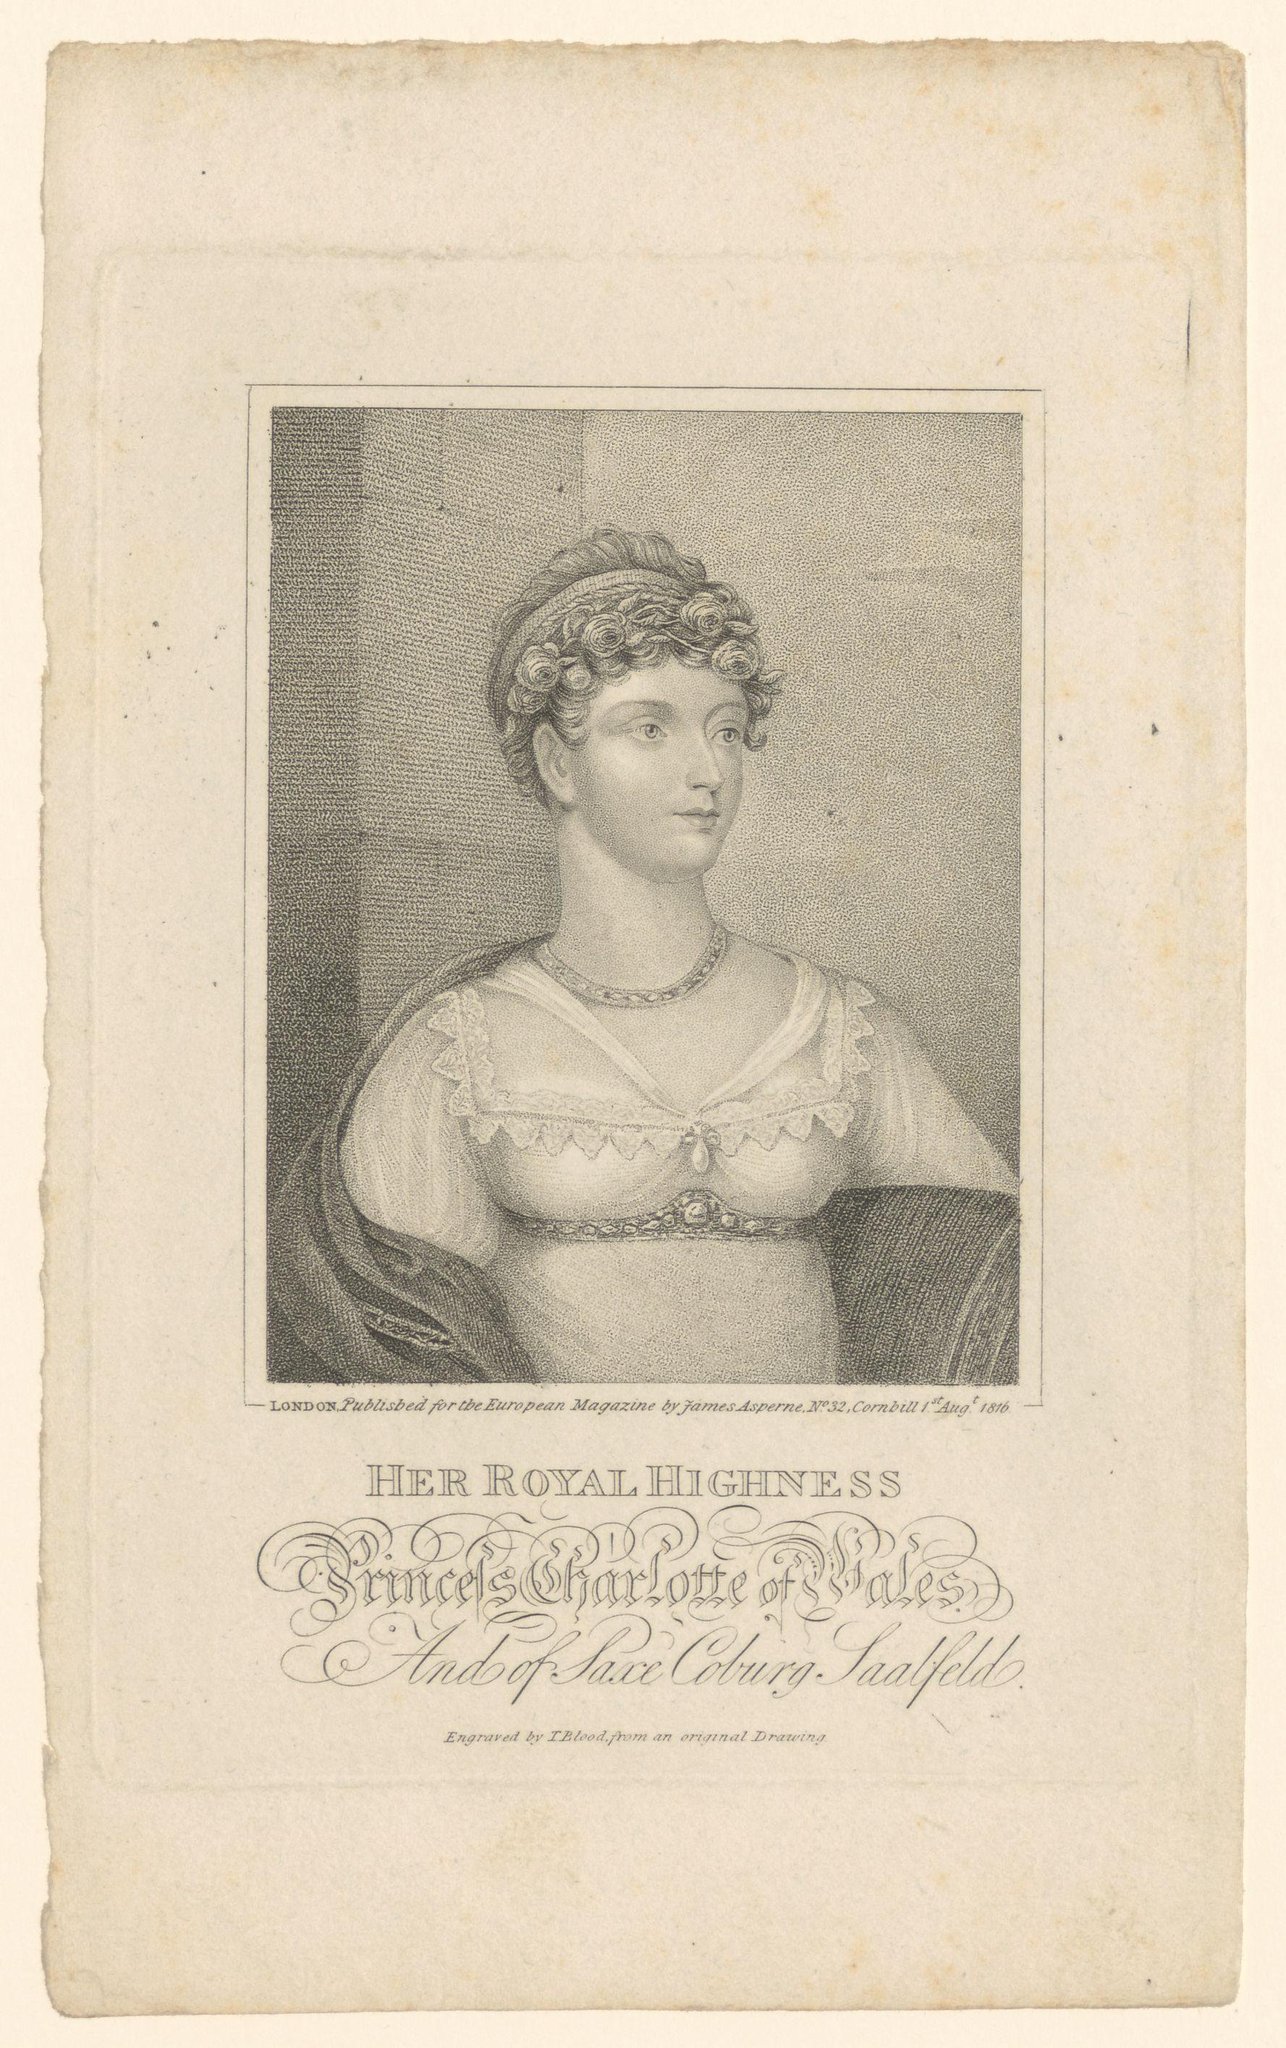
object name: print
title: Her Royal Highness Princess Charlotte of Wales and of Saxe Coburg Saalfeld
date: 1808-1816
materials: paper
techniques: etching, engraving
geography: london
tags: london, charlotte augusta (prinses van wales), historical persons, princess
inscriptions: collector's mark: Lugt 2228